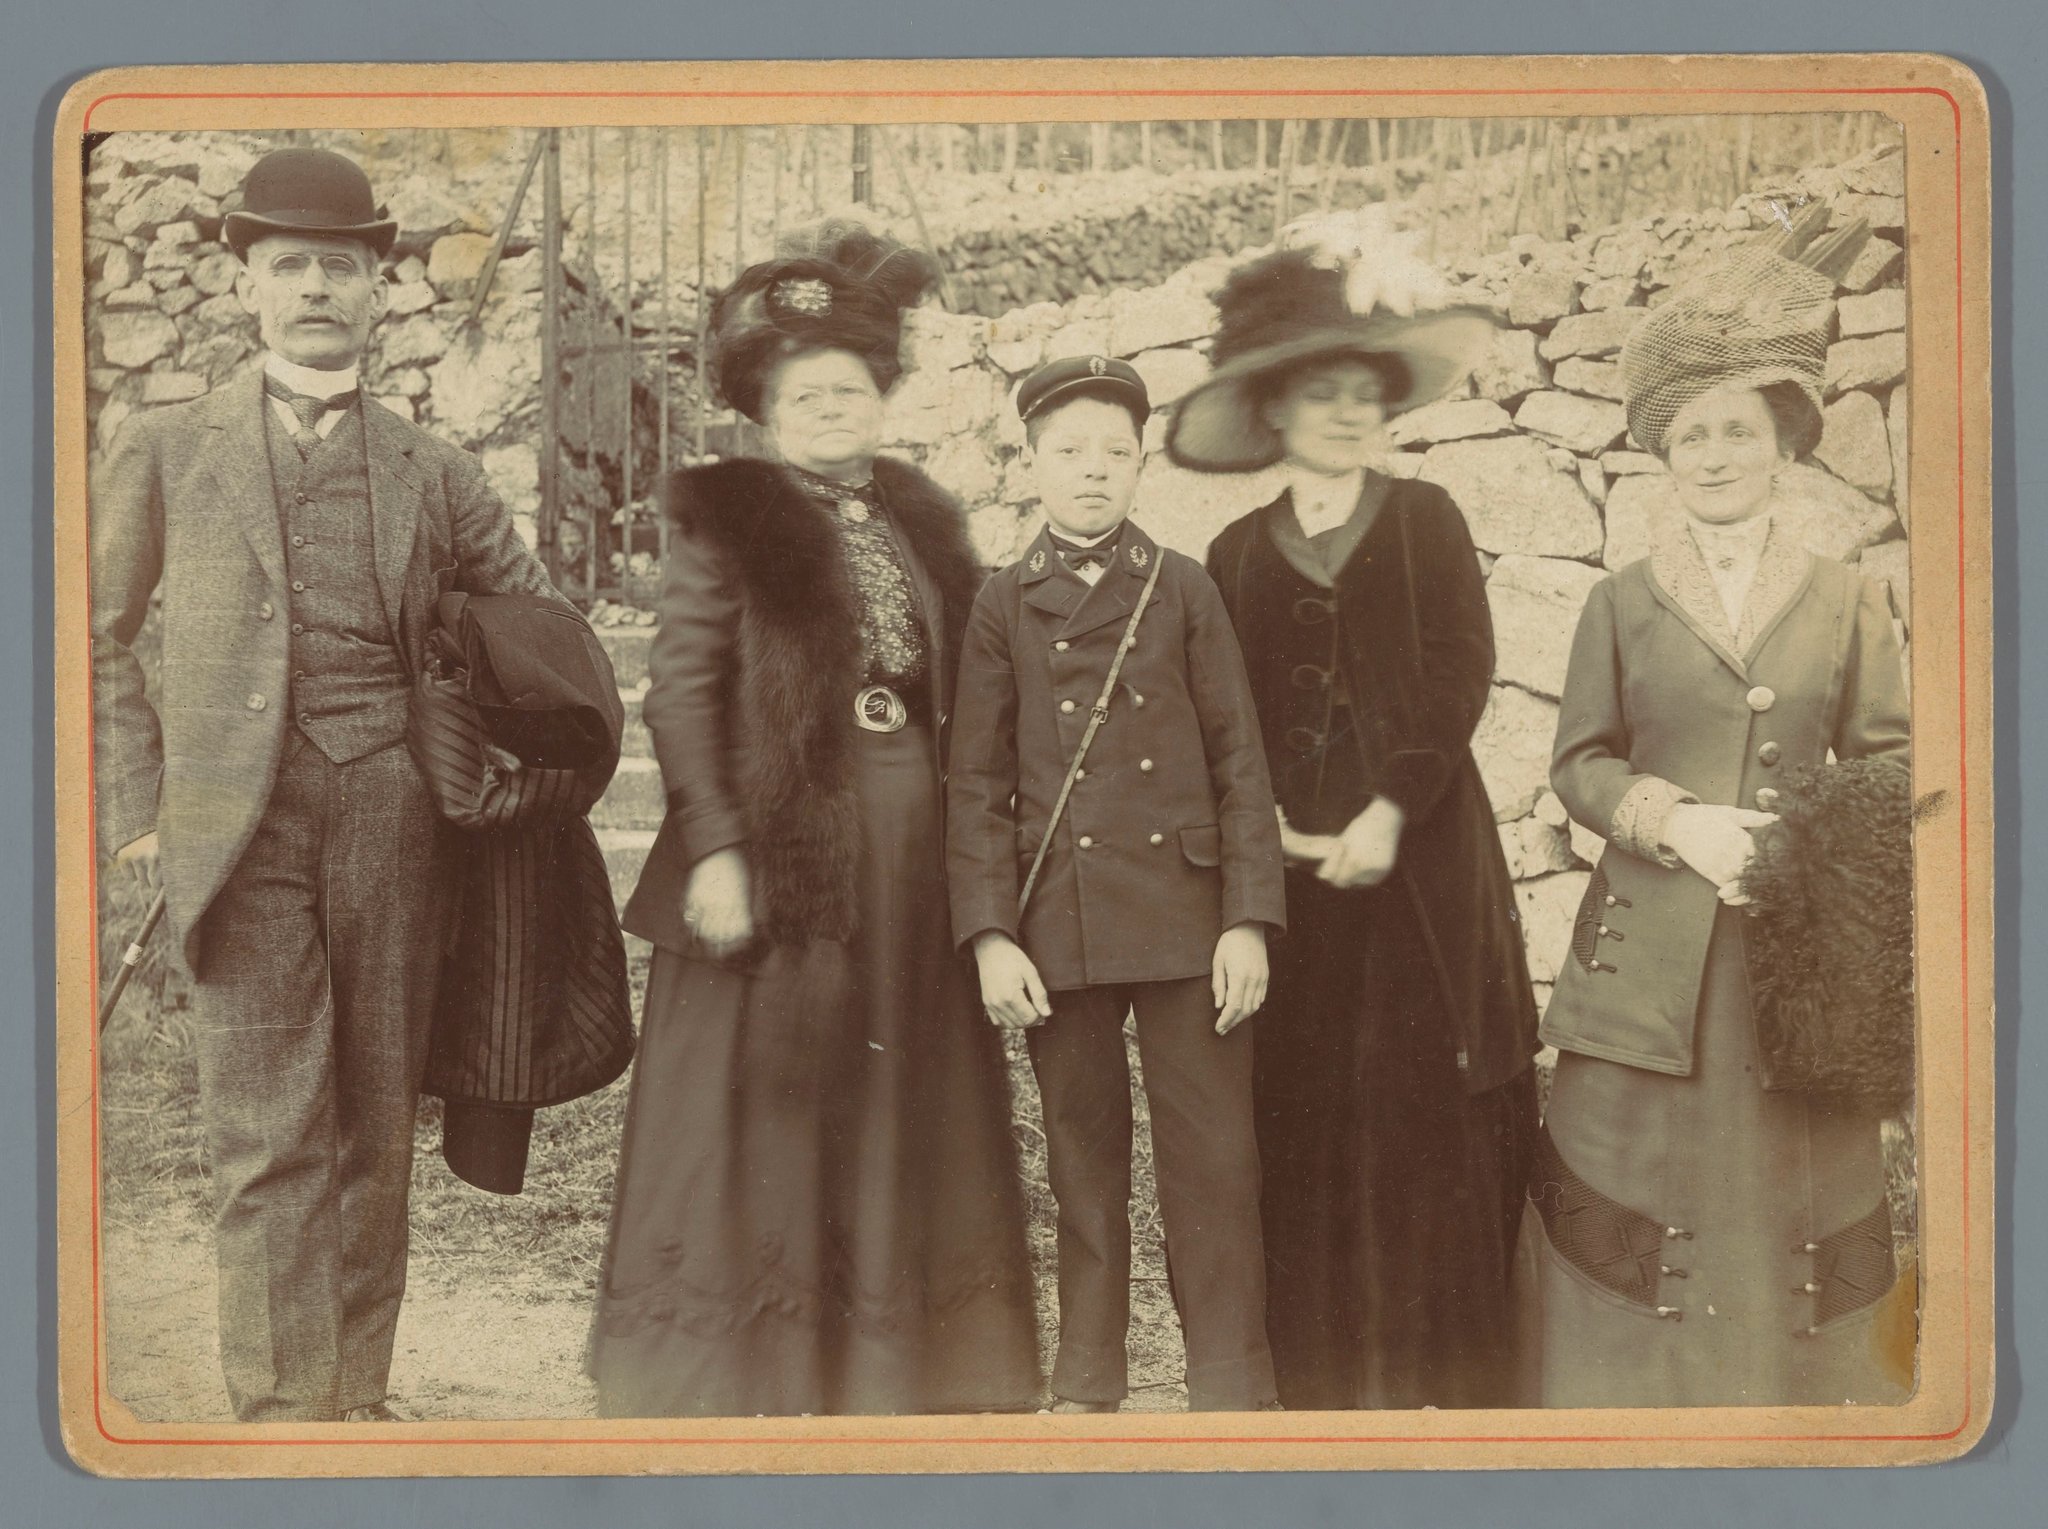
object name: photograph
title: Portret van een onbekende familie voor een stenen muur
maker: Anonymous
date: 1900-1915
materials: paper, cardboard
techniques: gelatin silver print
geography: netherlands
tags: family group, especially parents with their child(ren), fence, wall, paling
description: Hetzelfde gezelschap is geportretteerd op RP-F-F20413.